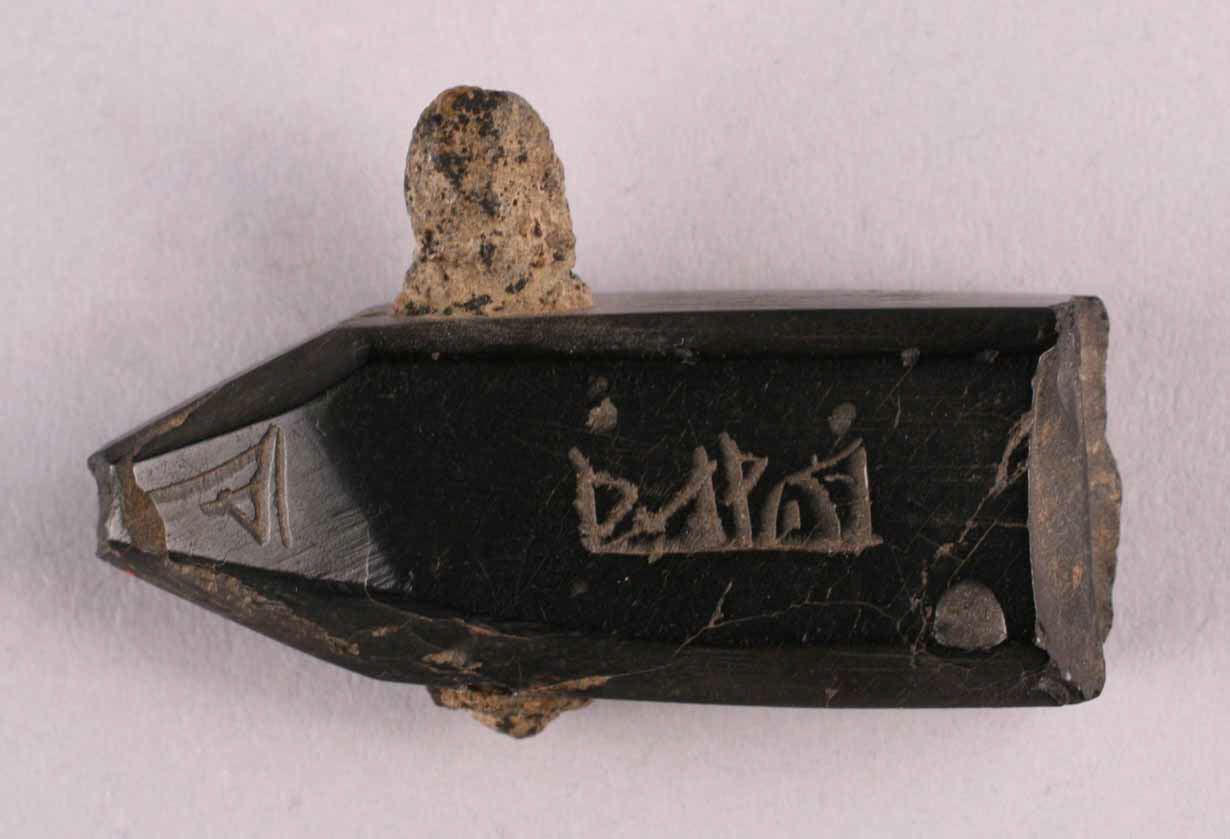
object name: pendant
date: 701-1200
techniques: carving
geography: iran